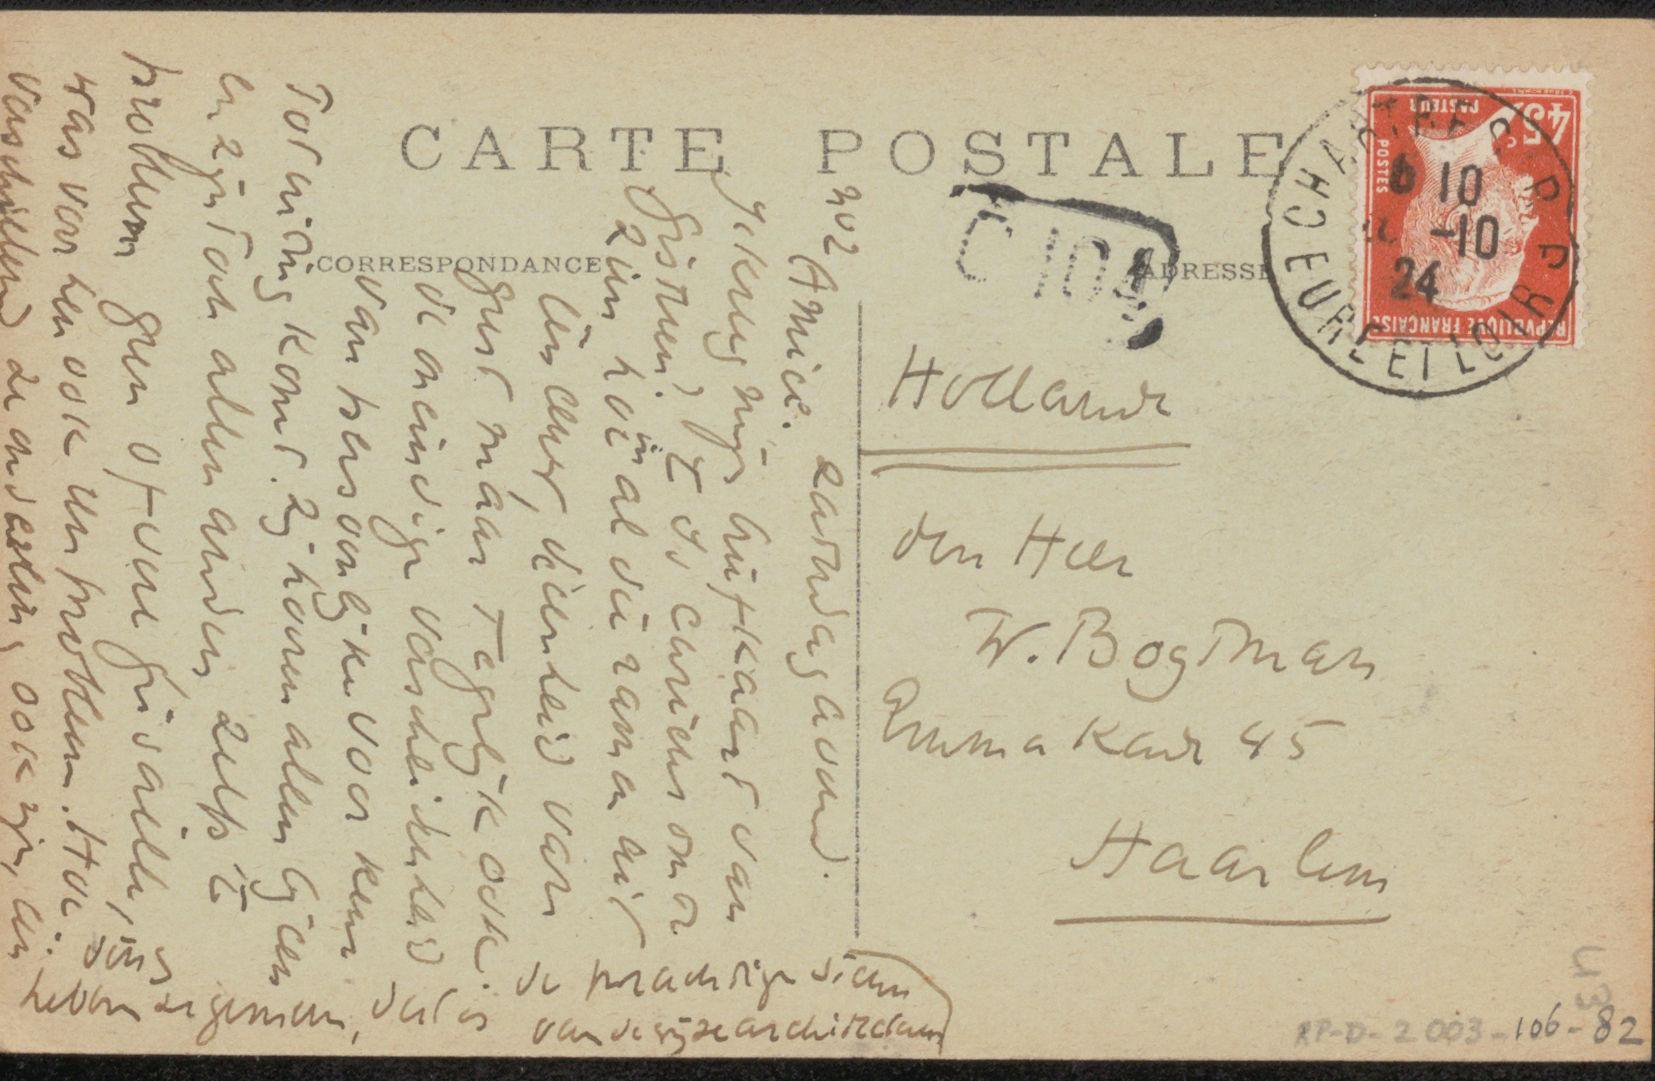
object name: ansichtkaart, prentbriefkaart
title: Prentbriefkaart aan Willem Bogtman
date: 1924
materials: cardboard, ink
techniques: photograph, pen, writing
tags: haarlem, willem bogtman, applied arts, arts and crafts; industrial design